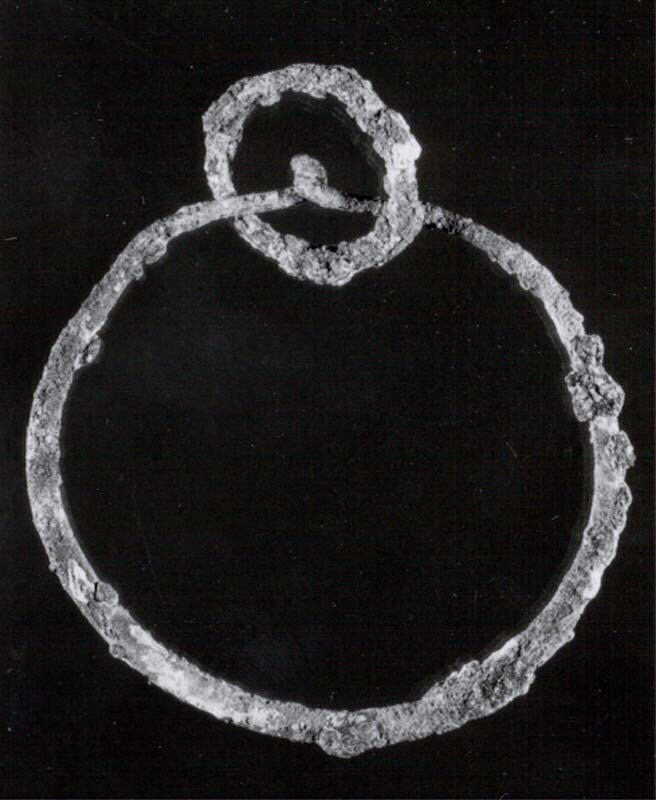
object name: earring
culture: iranian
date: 1200-801 BCE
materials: bronze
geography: iran